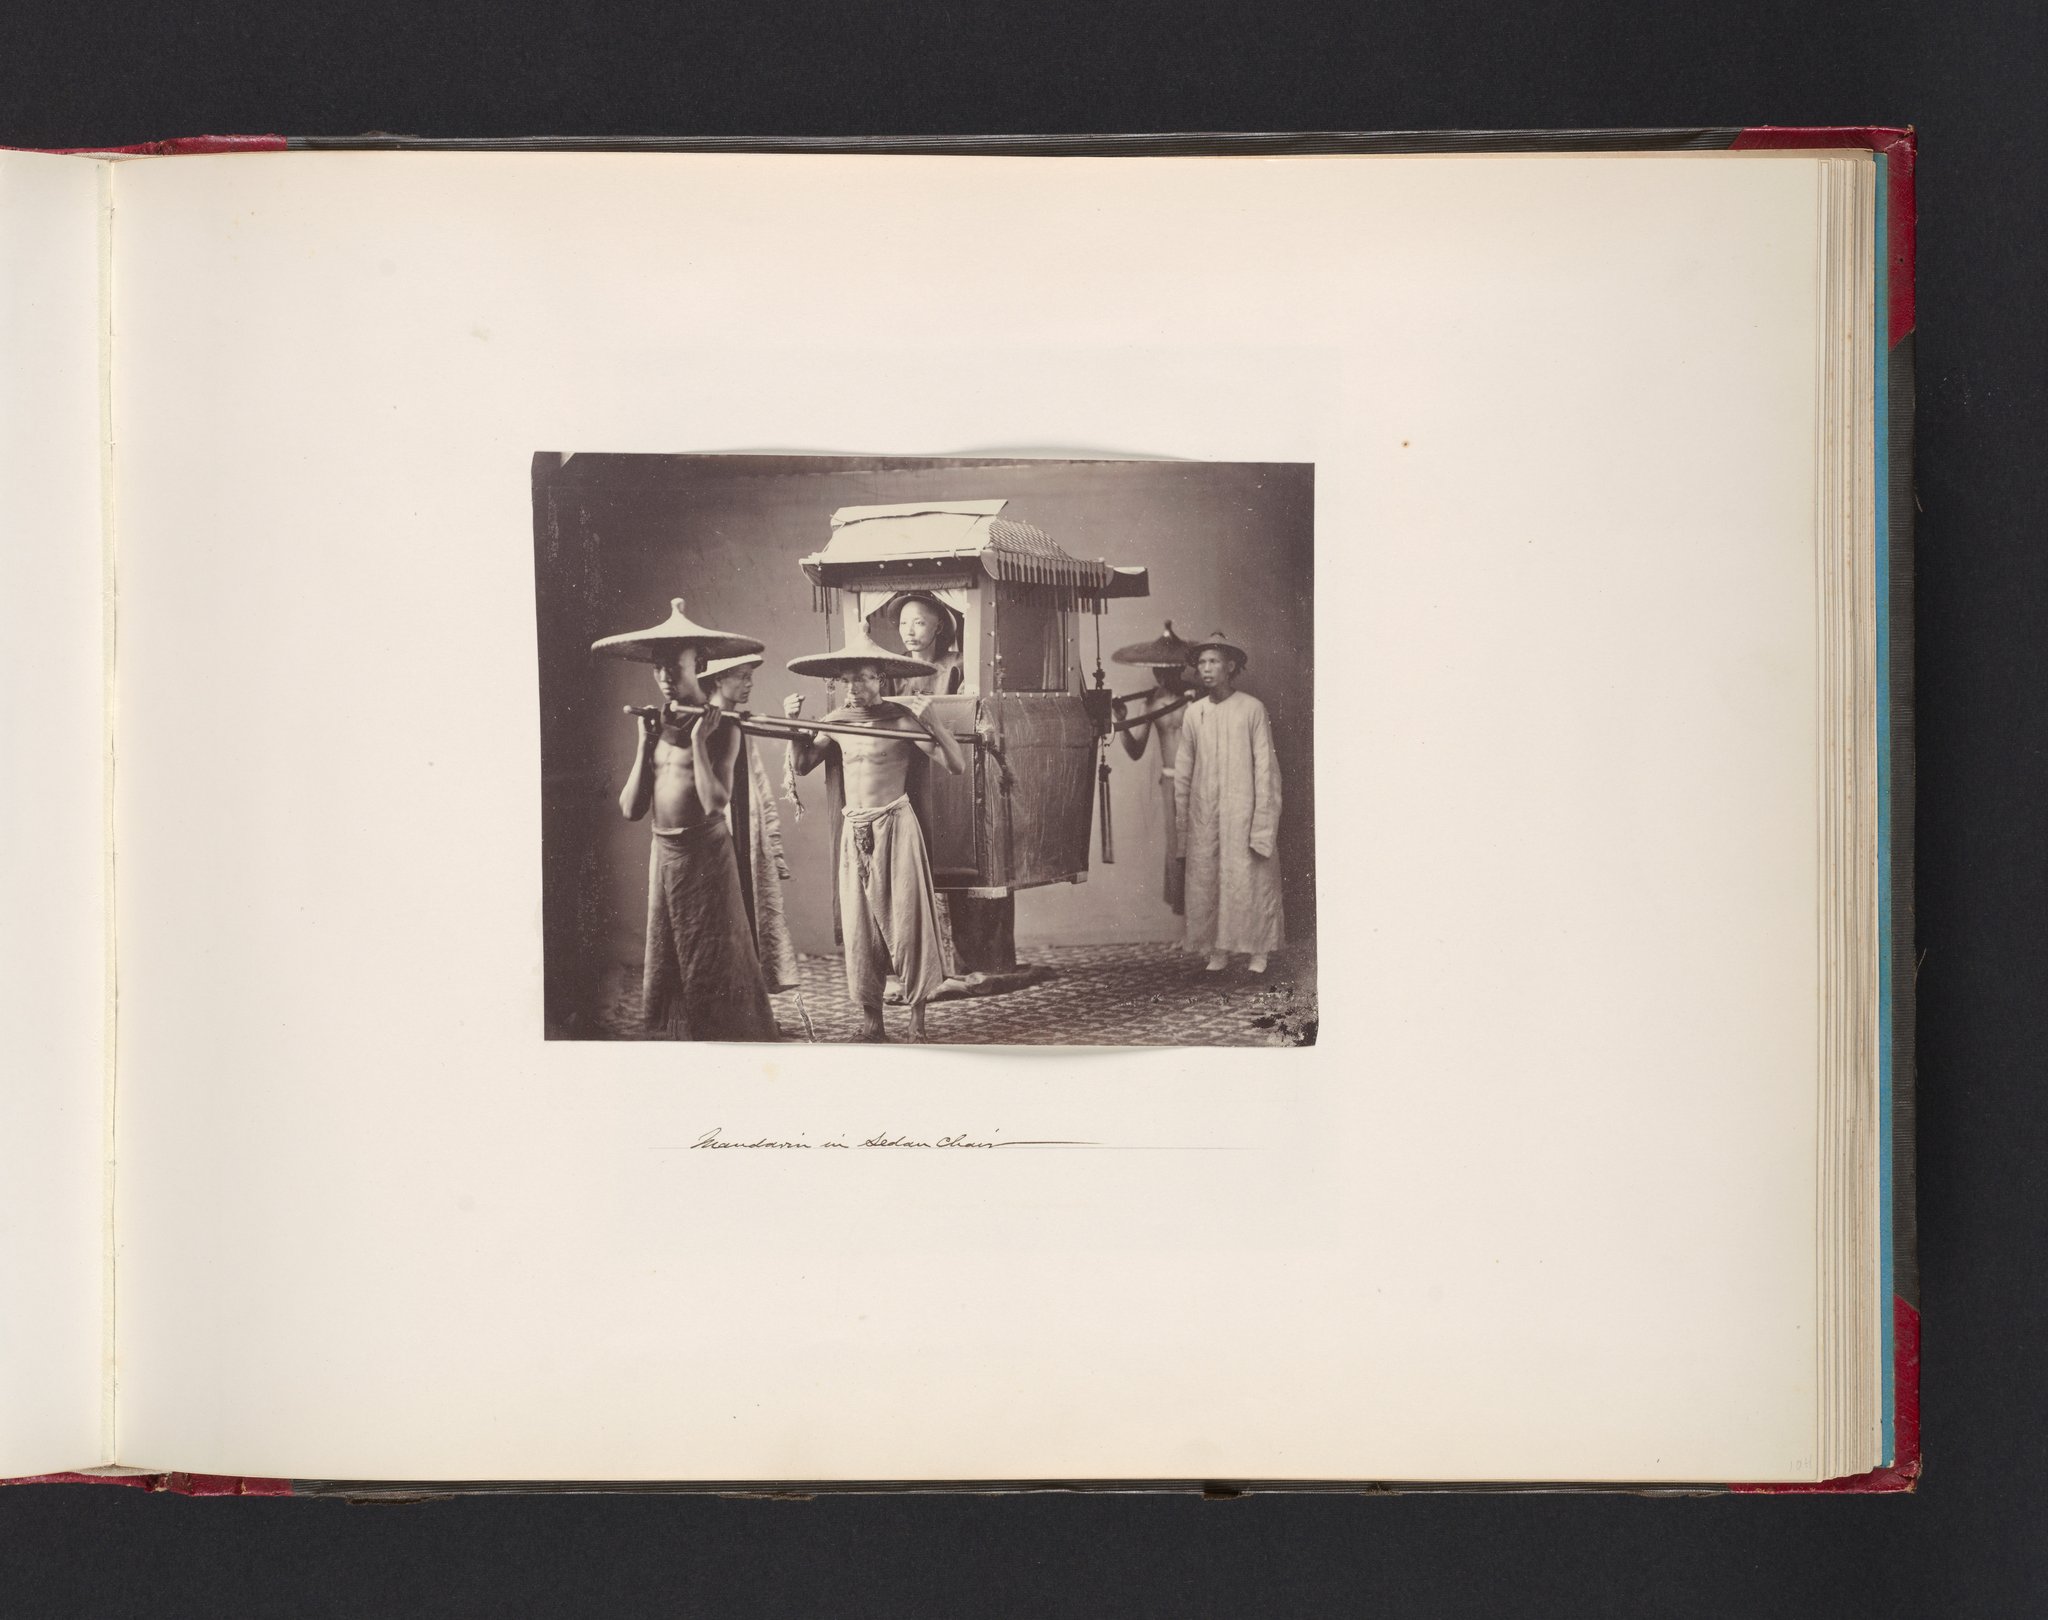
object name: photograph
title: Mandarin in Sedan Chair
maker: john thomson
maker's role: artist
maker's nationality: british, scottish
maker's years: 1837-1921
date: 1865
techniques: albumen silver print, glass negative